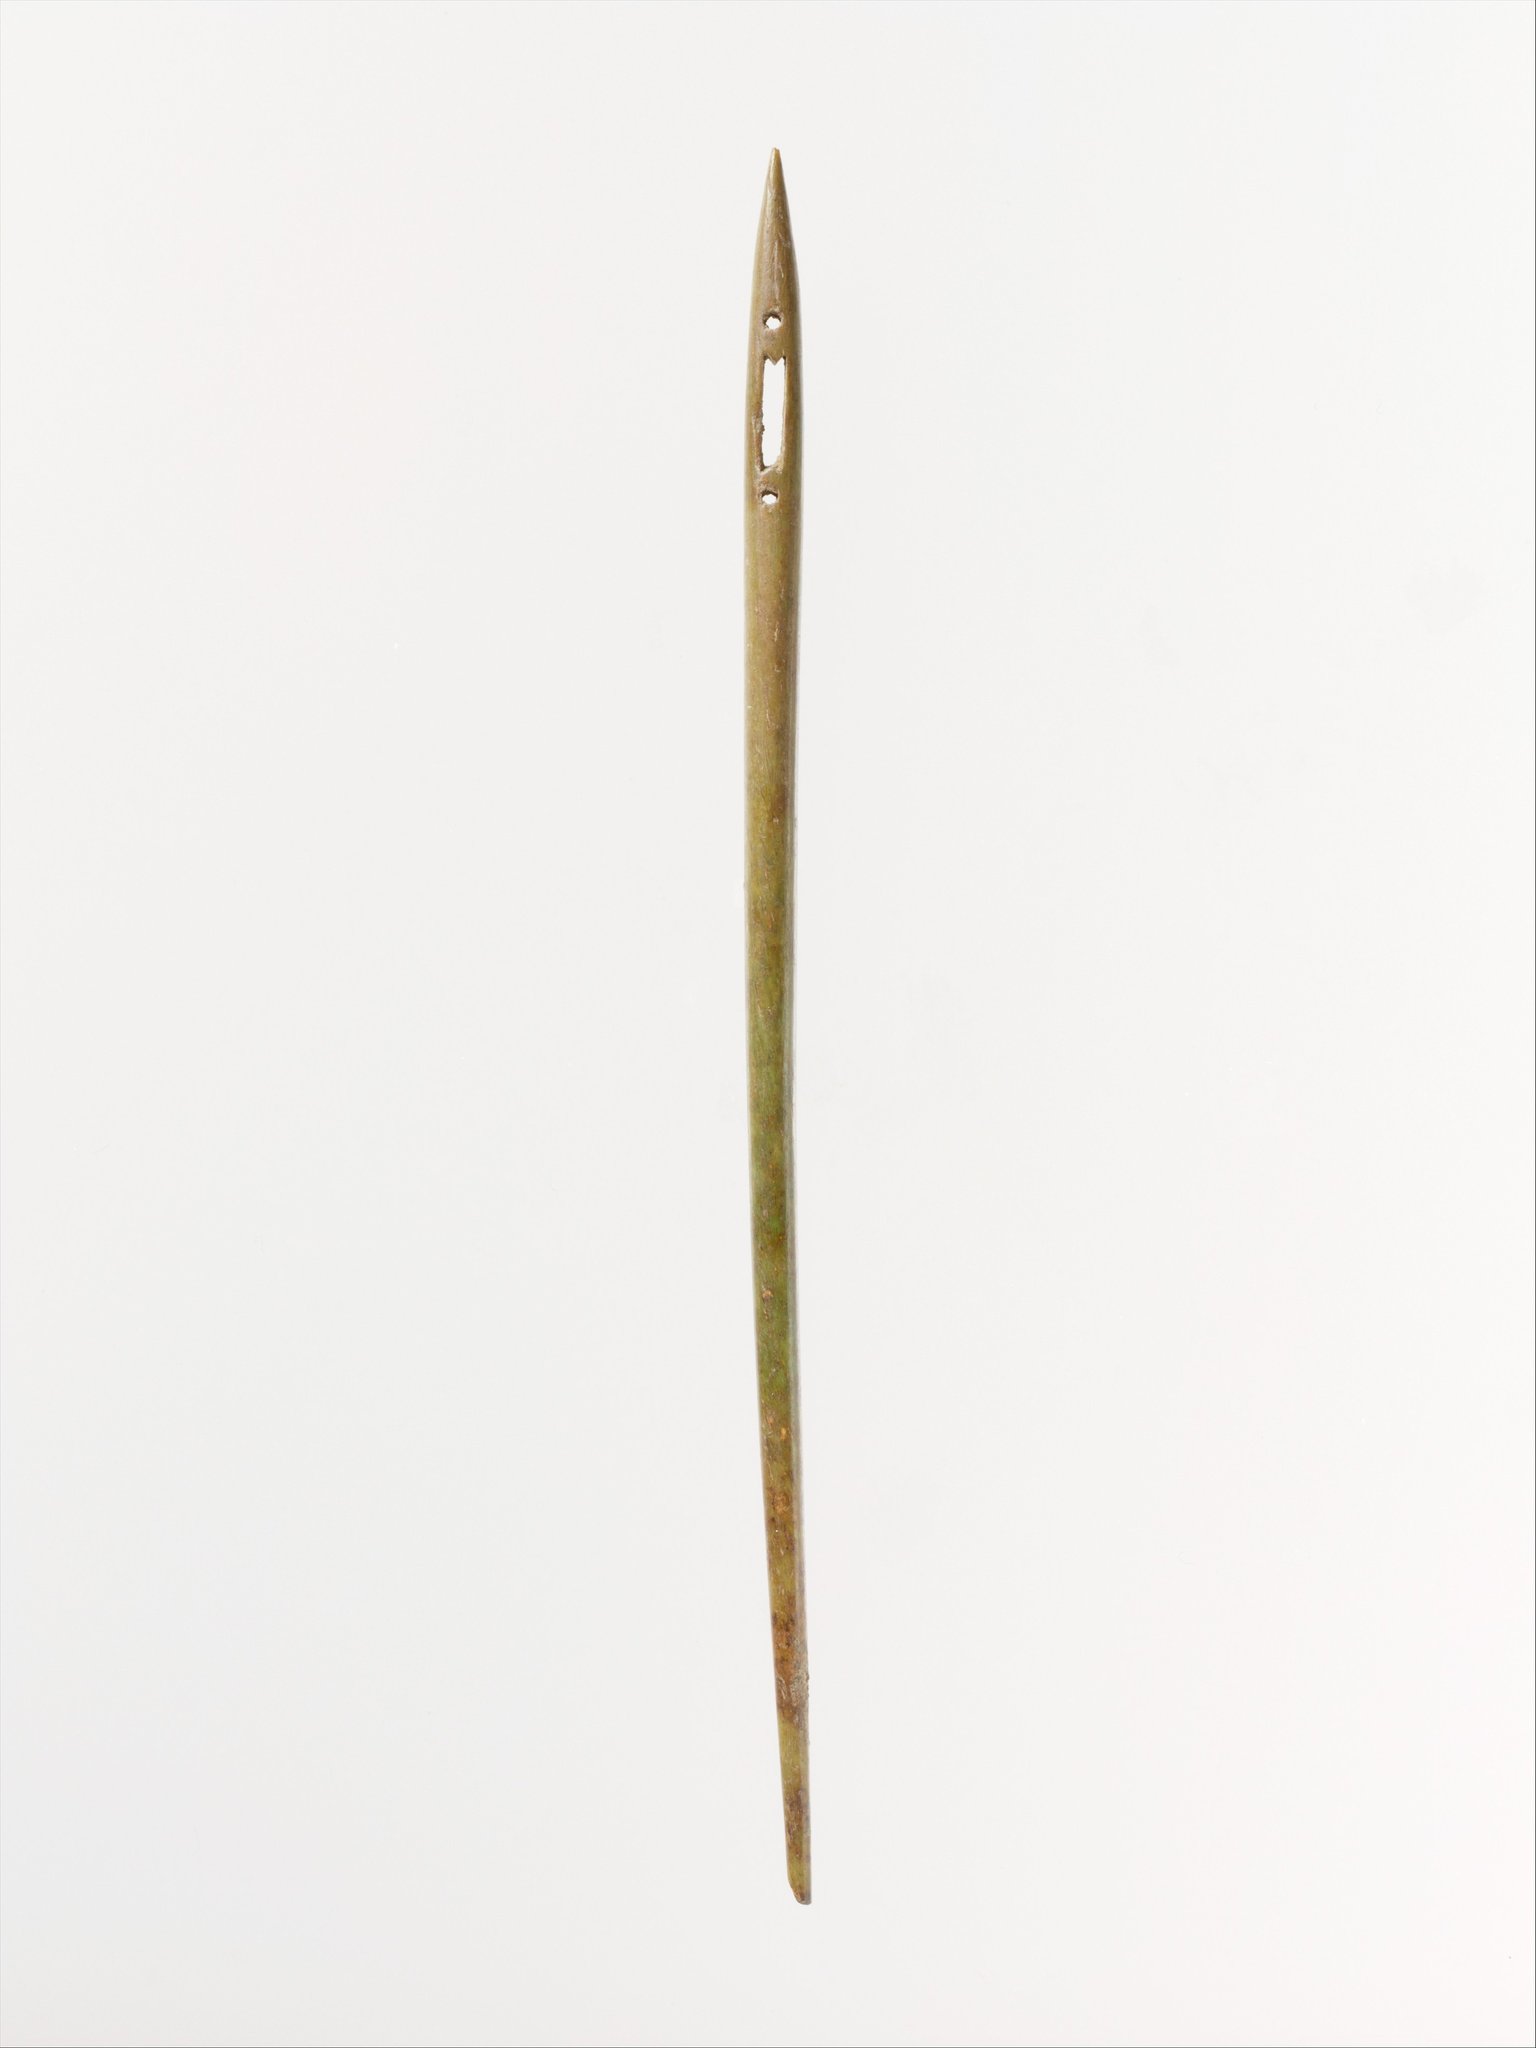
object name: needle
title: Ivory needle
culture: roman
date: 101-300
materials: ivory